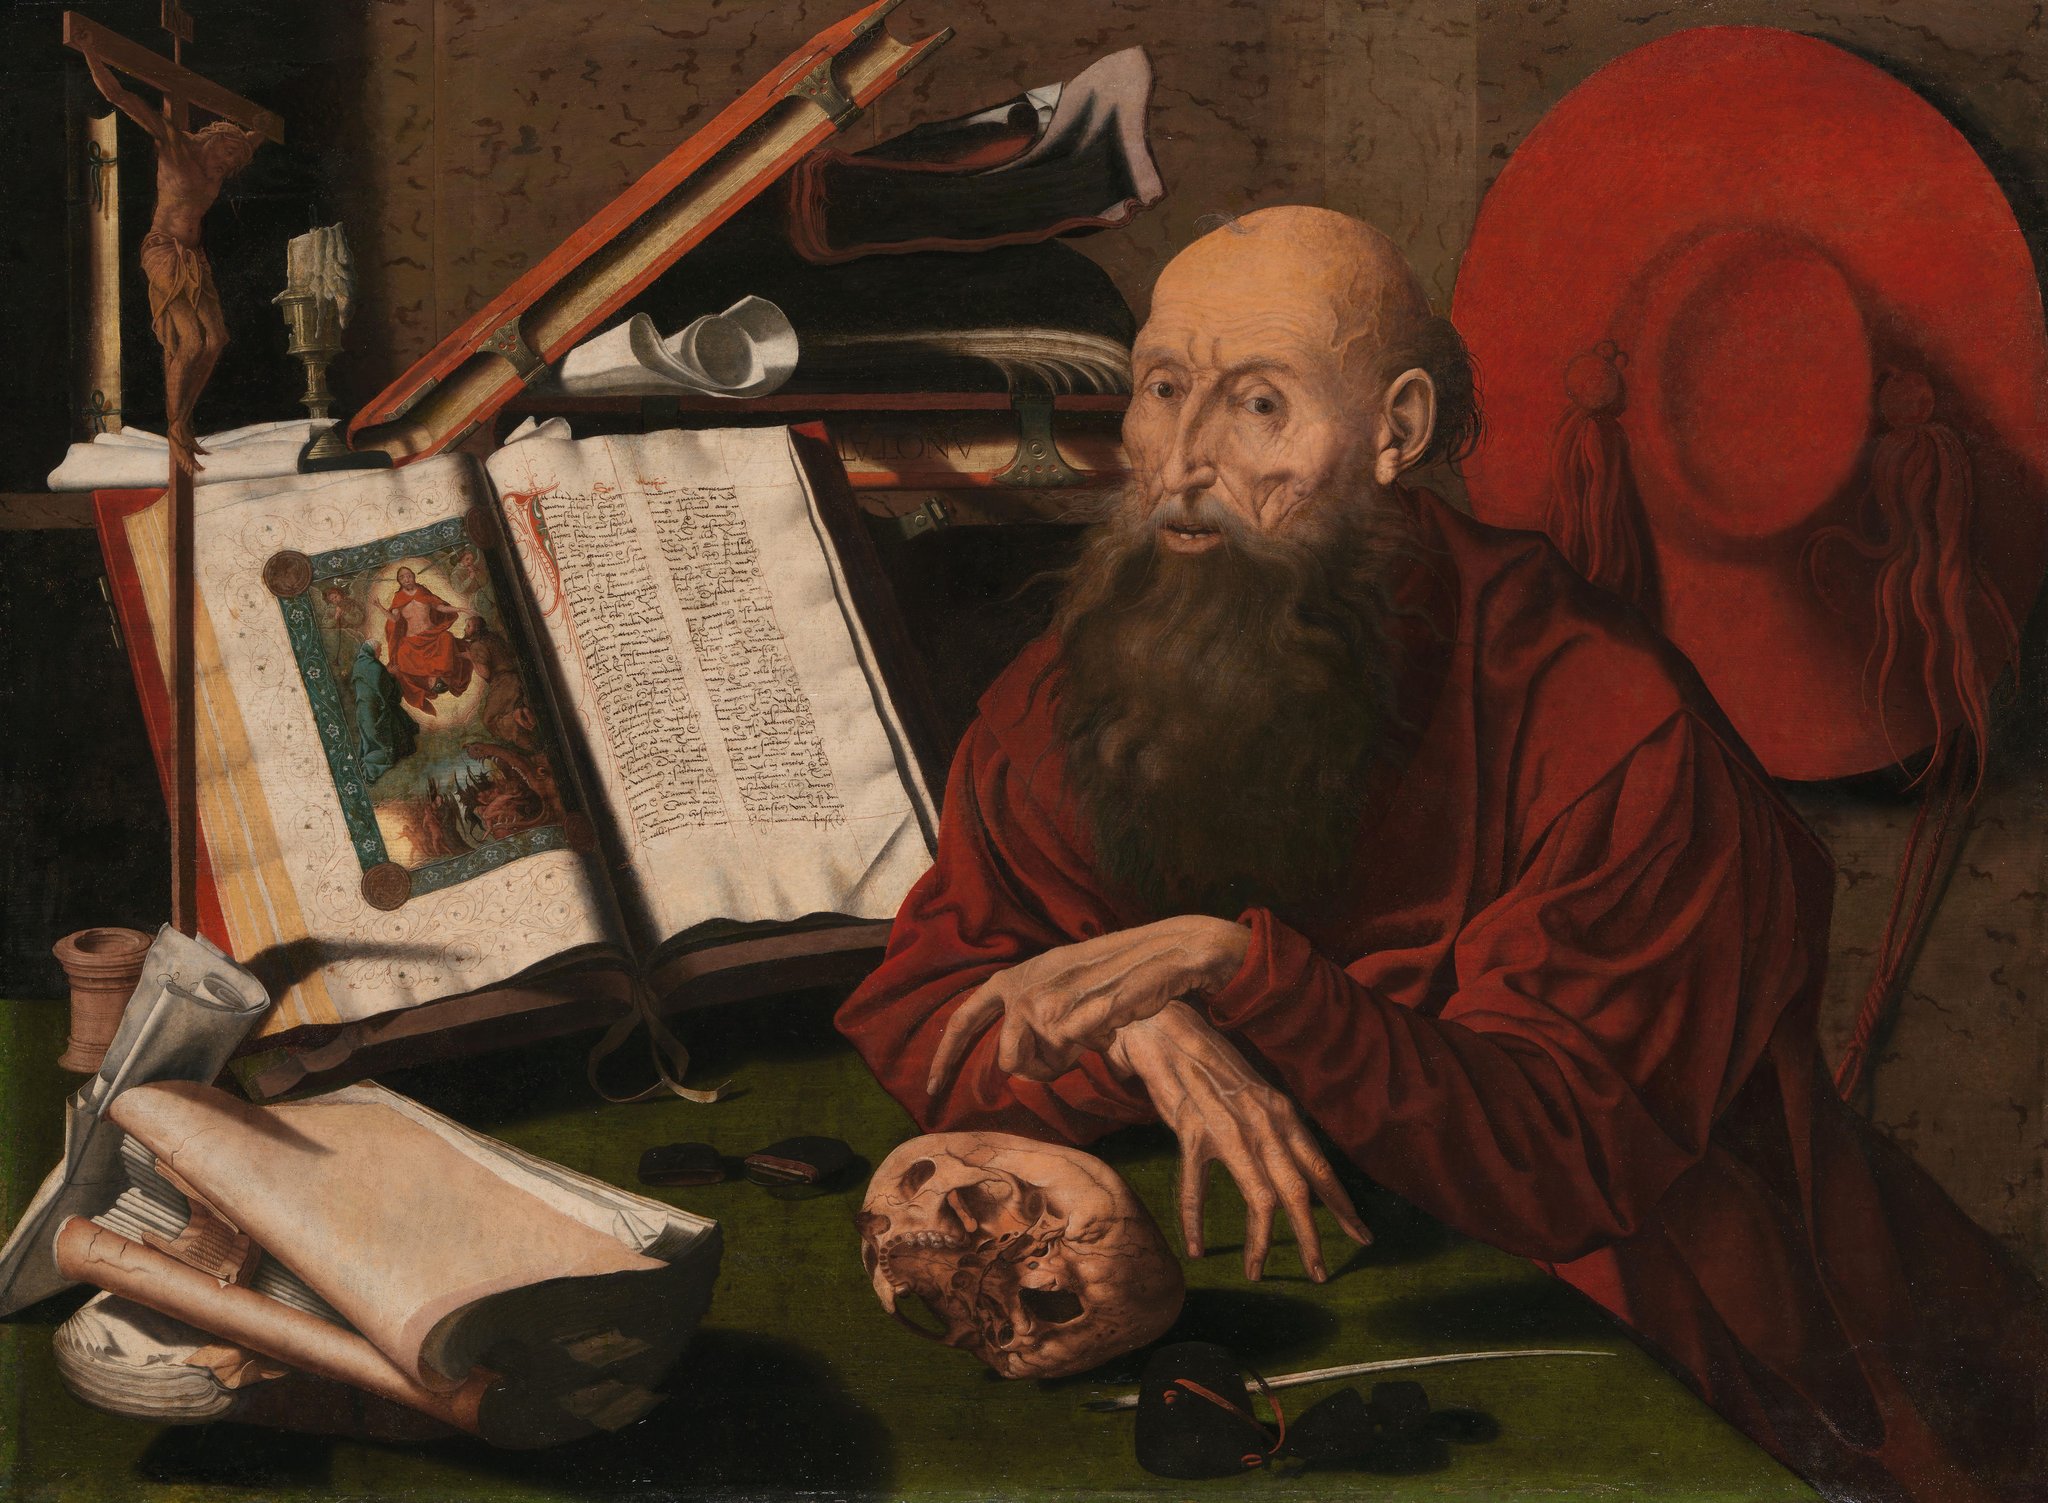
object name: painting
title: St Jerome in his study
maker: marinus van reymerswale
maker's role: painter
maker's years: 1490-1557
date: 1535-1545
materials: oil, paint, panel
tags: the monk and hermit jerome (hieronymus); possible attributes: book, cardinal's hat, crucifix, hour-glass, lion, skull, stone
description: De heilige Hieronymus in zijn studeervertrek, wijzend met zijn linkerhand naar een schedel. Op zijn werktafel liggen verder een openstaande boek waarin een miniatuur van het Laatste Oordeel, boeken en paperassen, een bril of loep in een houder, pen en inkt, een kruisbeeld en een kaars. Aan de muur hangt zijn kardinaalshoed. Herhaling naar het origineel uit 1541 in het Prado te Madrid.